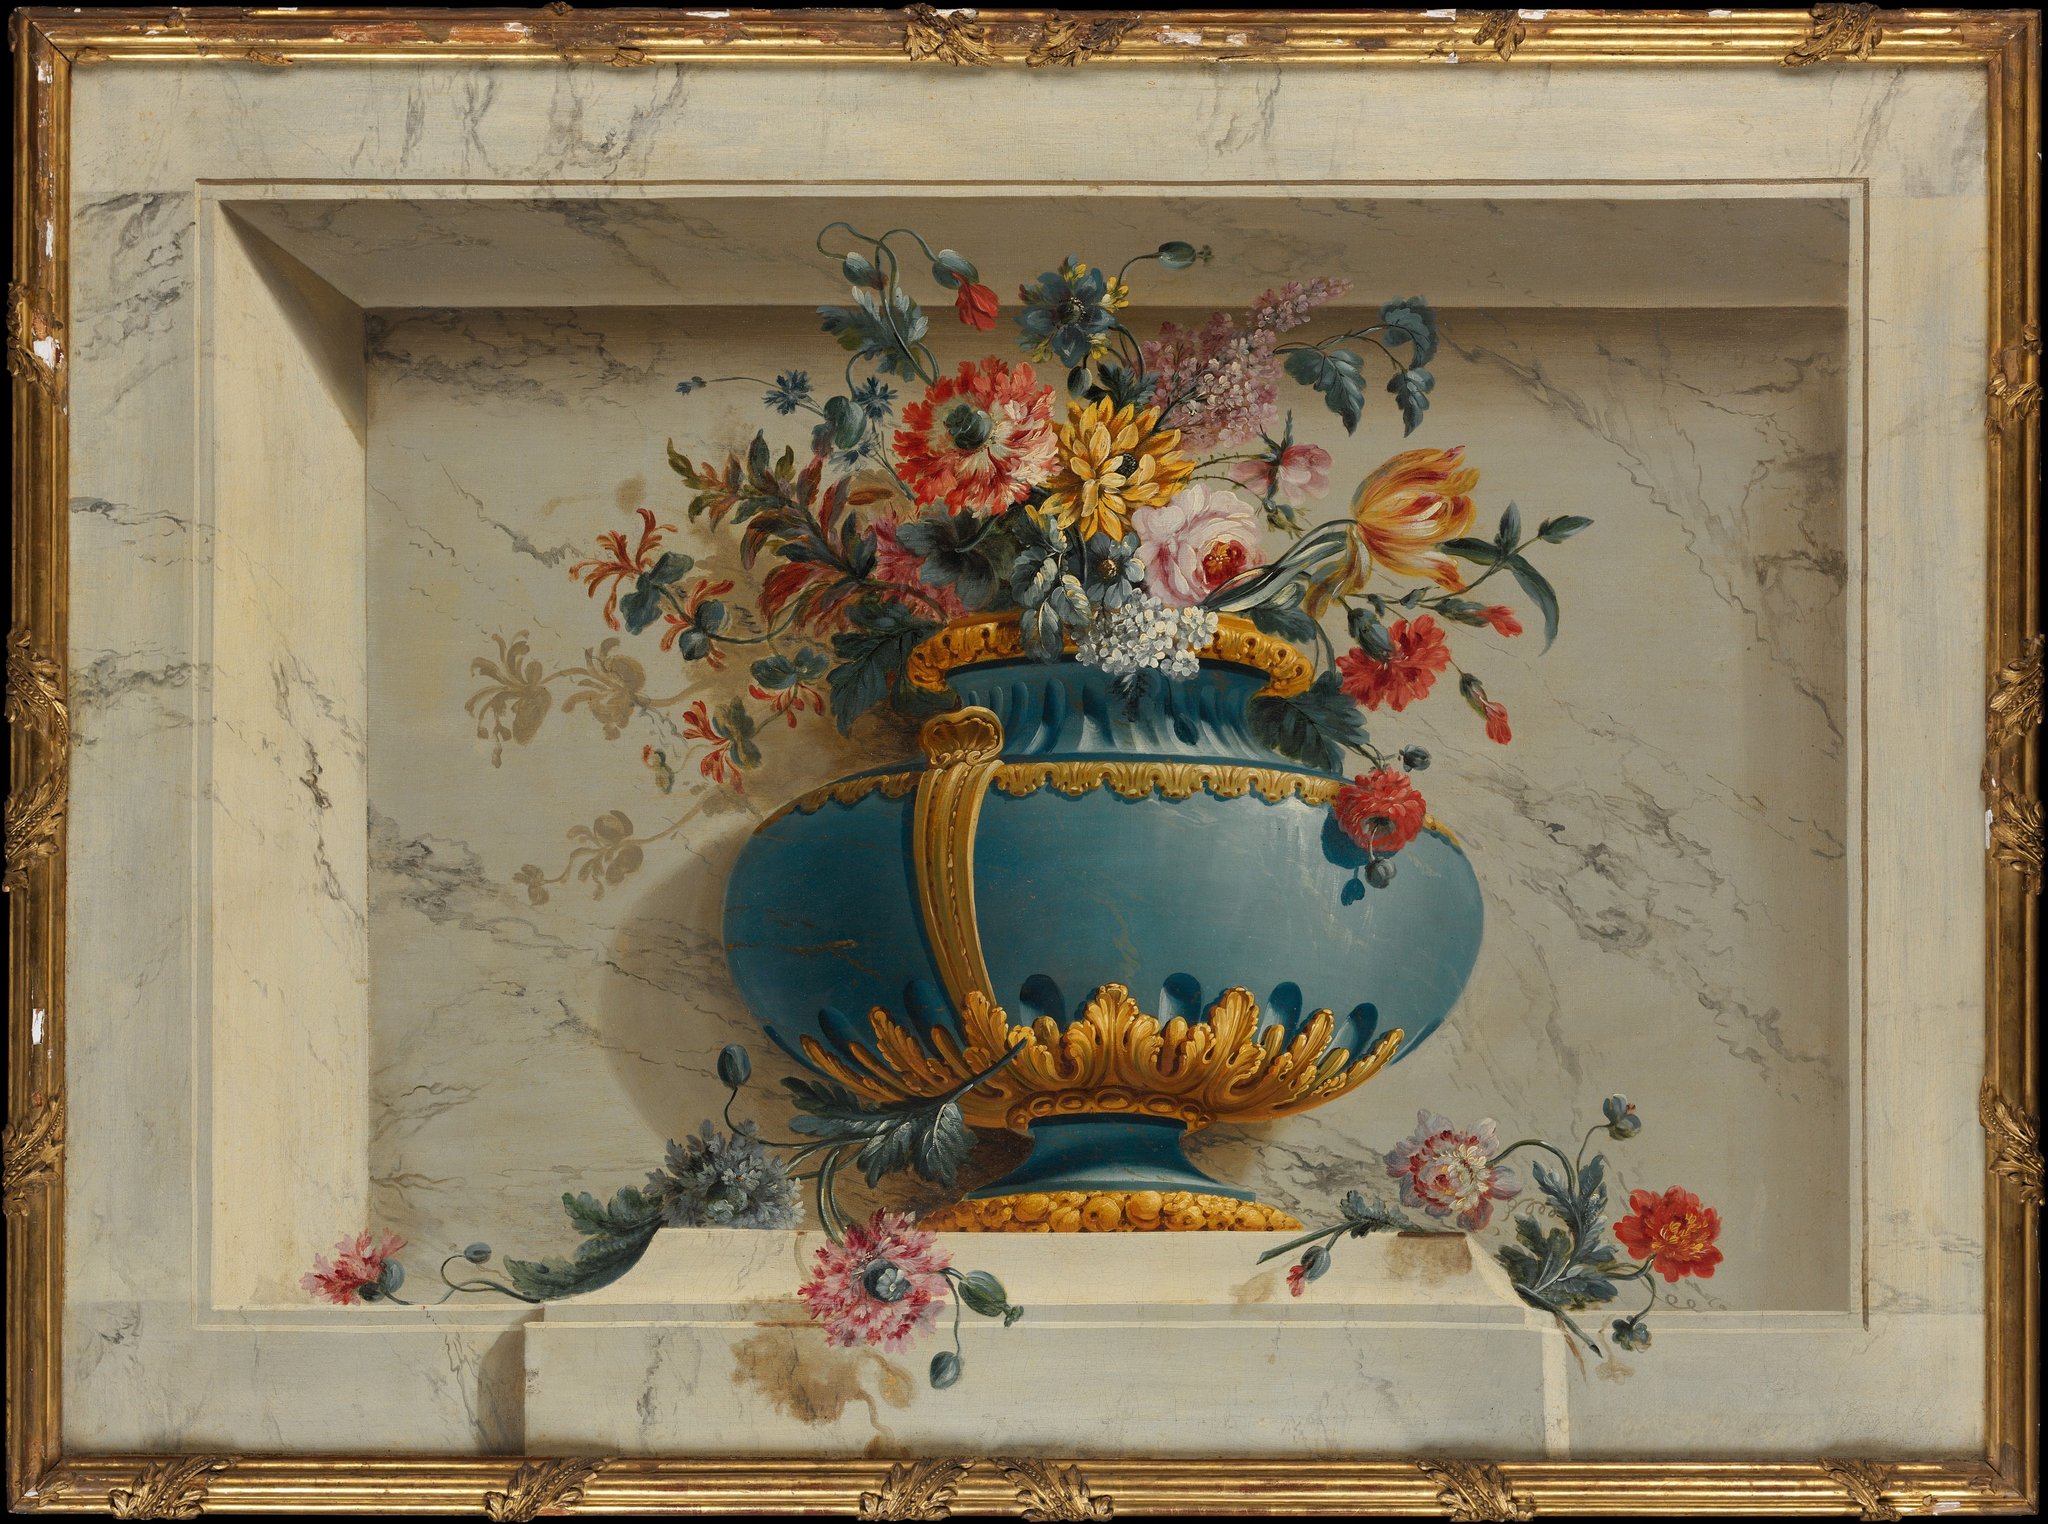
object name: painting, overdoor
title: Vase of Flowers in a Niche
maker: michel bruno bellengé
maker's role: artist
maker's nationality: french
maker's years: 1726-1793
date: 1746-1793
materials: canvas, oil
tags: flowers,vases